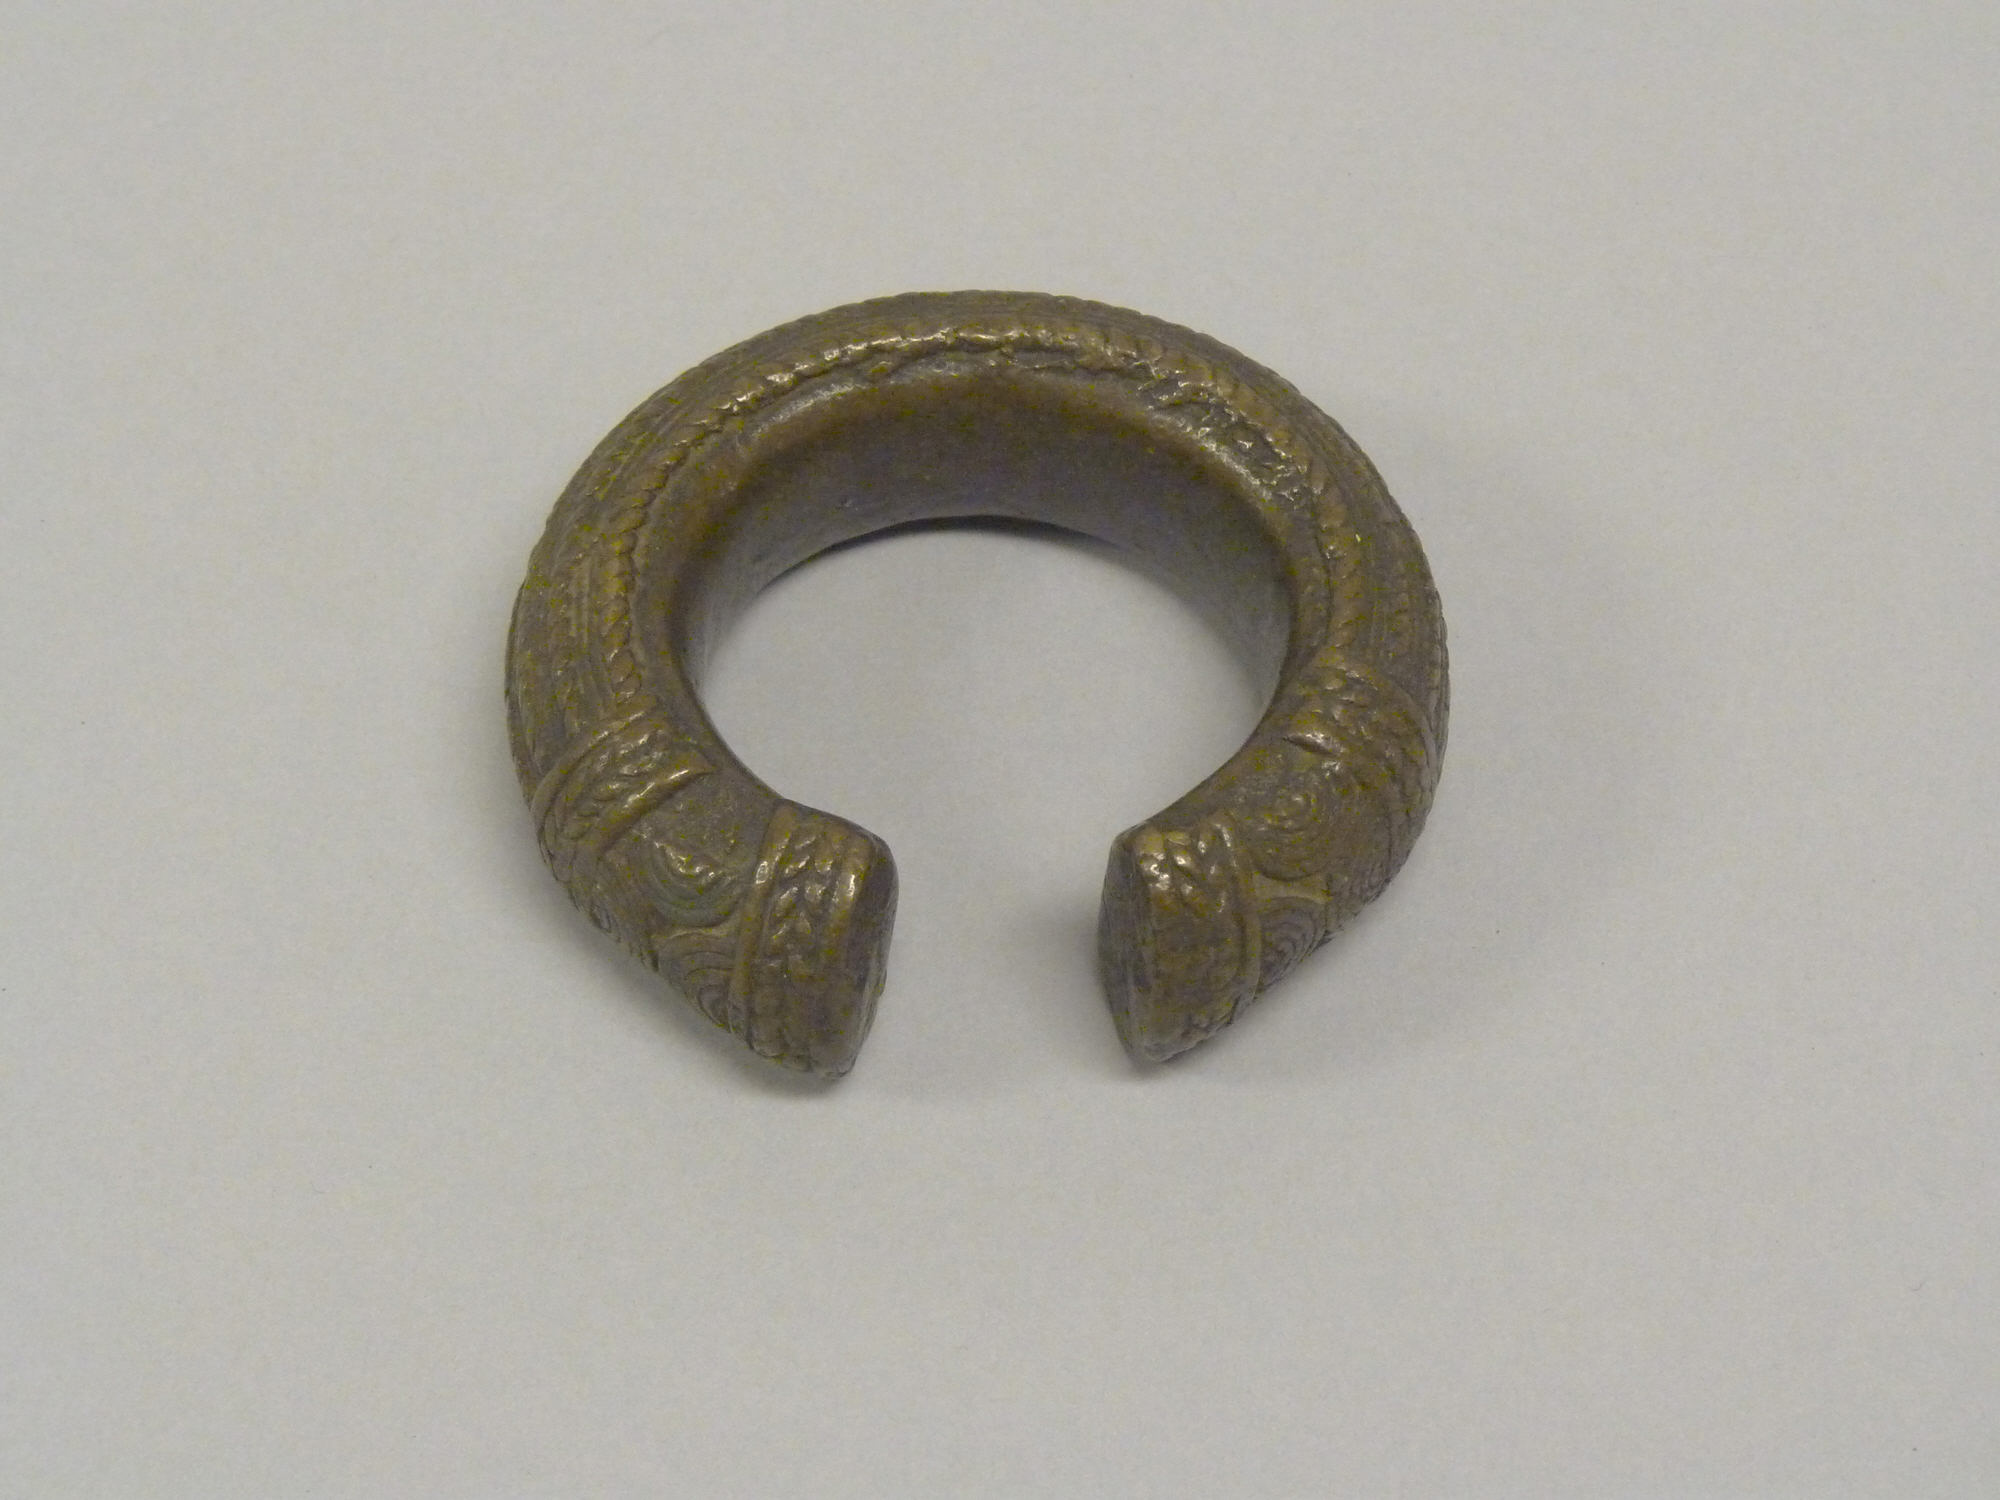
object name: anklet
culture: vietnamese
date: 500 BCE-300 CE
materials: bronze